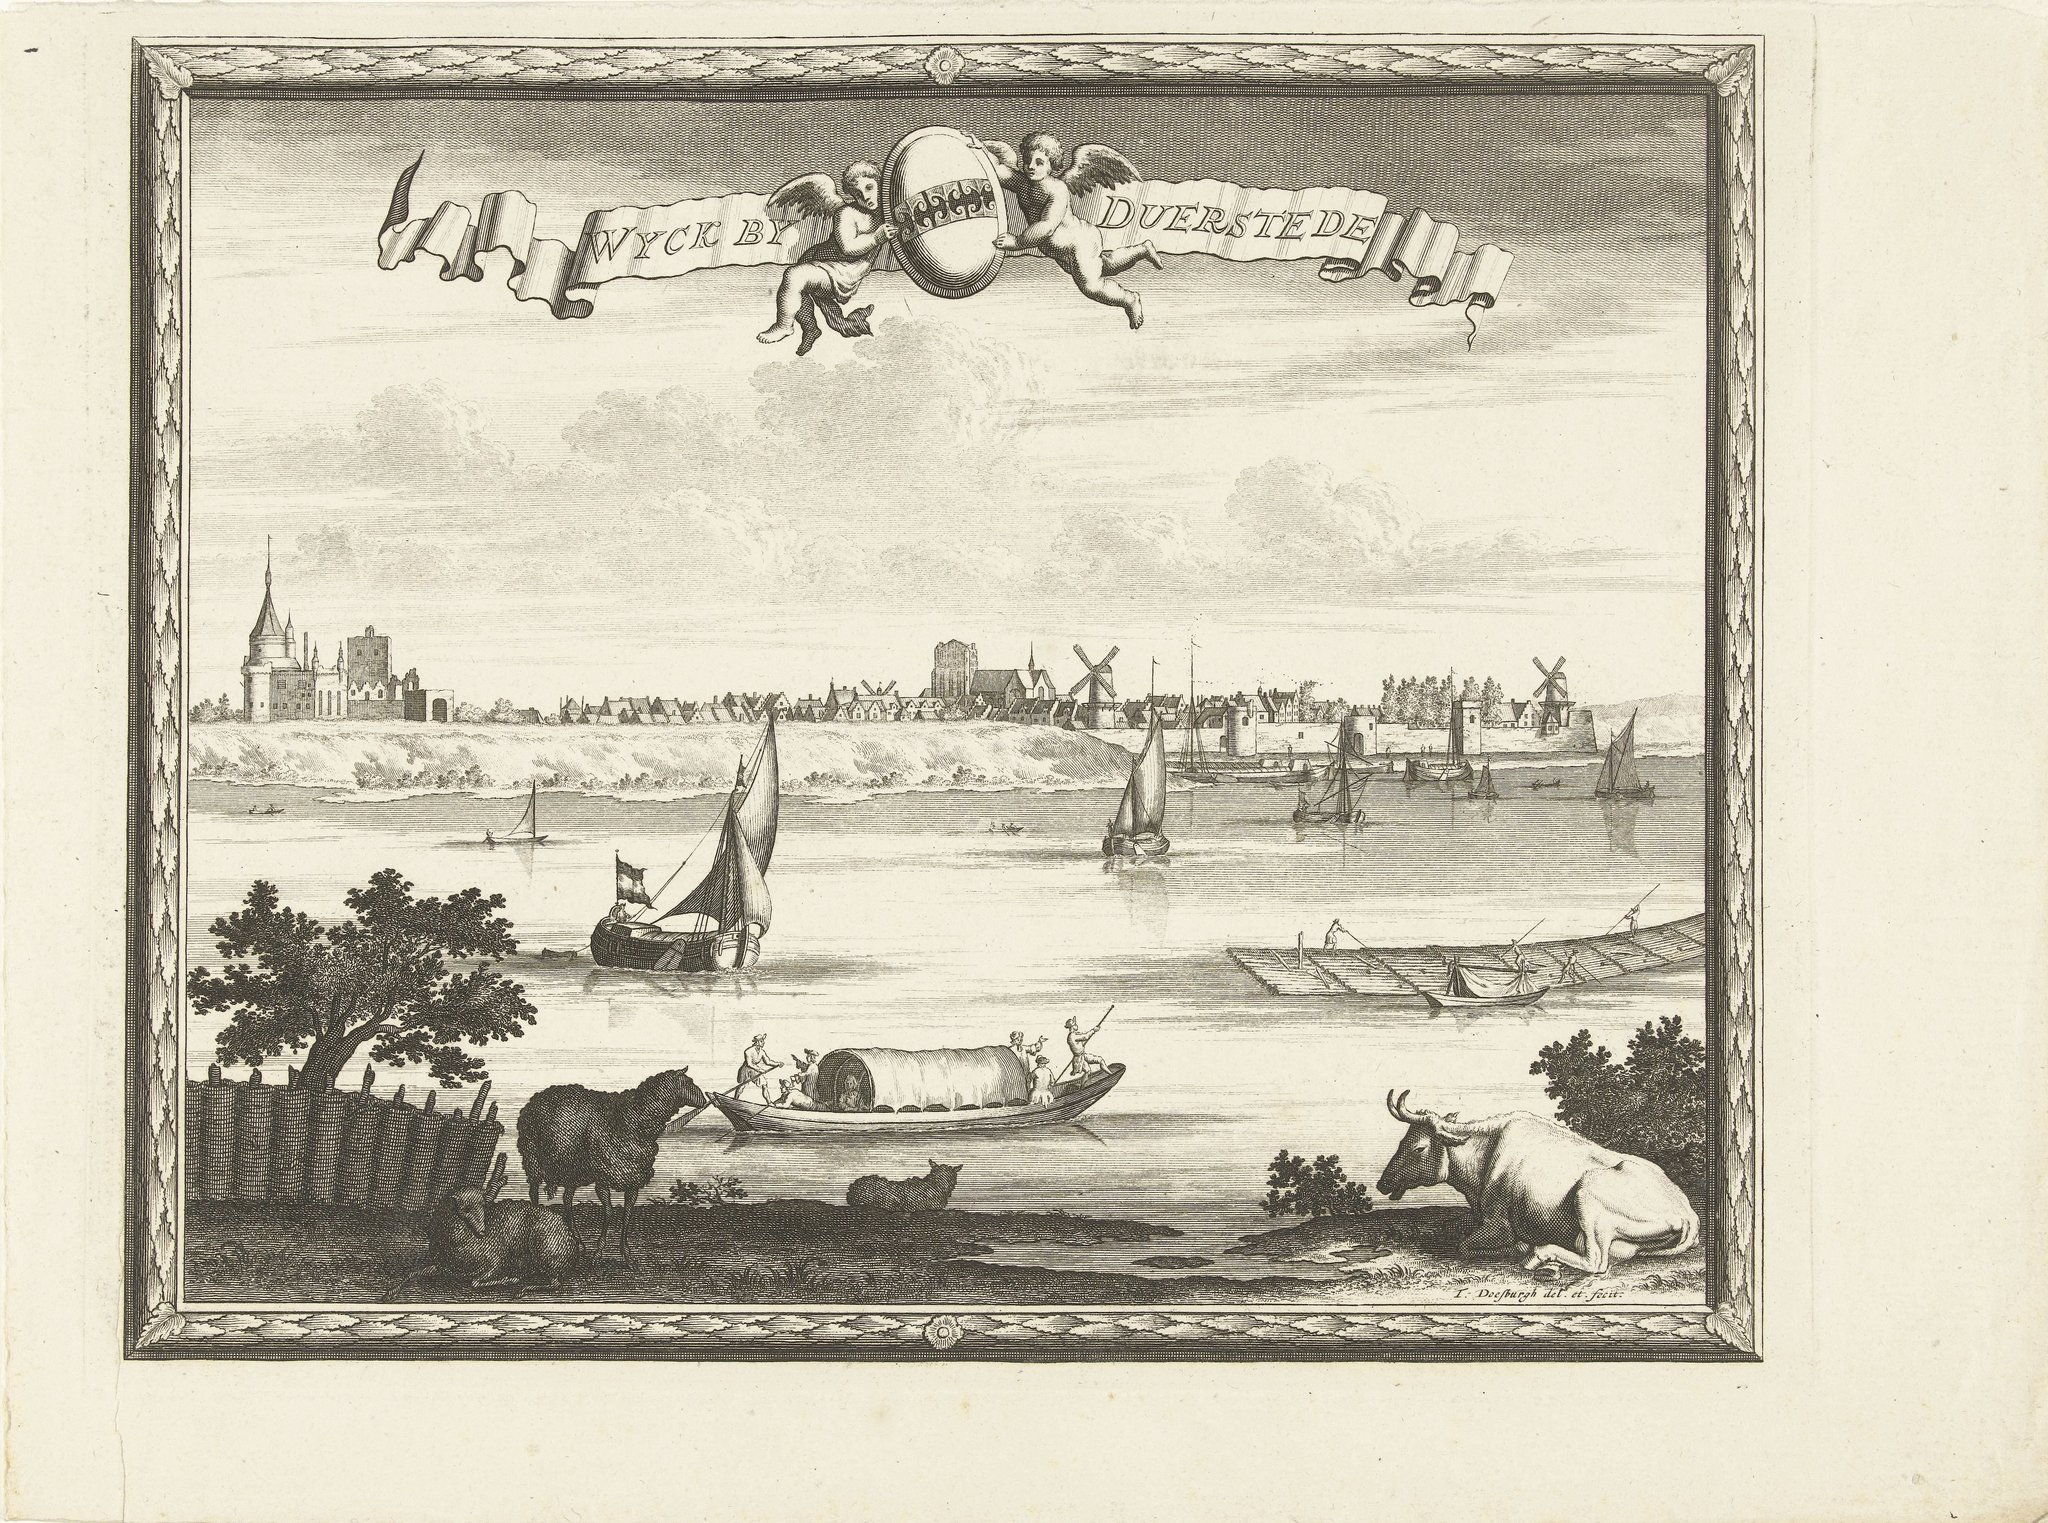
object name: print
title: Gezicht op Wijk bij Duurstede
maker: thomas doesburgh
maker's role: print maker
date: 1692-1714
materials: paper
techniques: etching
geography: netherlands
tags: river, prospect of city, town panorama, silhouette of city, wijk bij duurstede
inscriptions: collector's mark: Lugt 2228